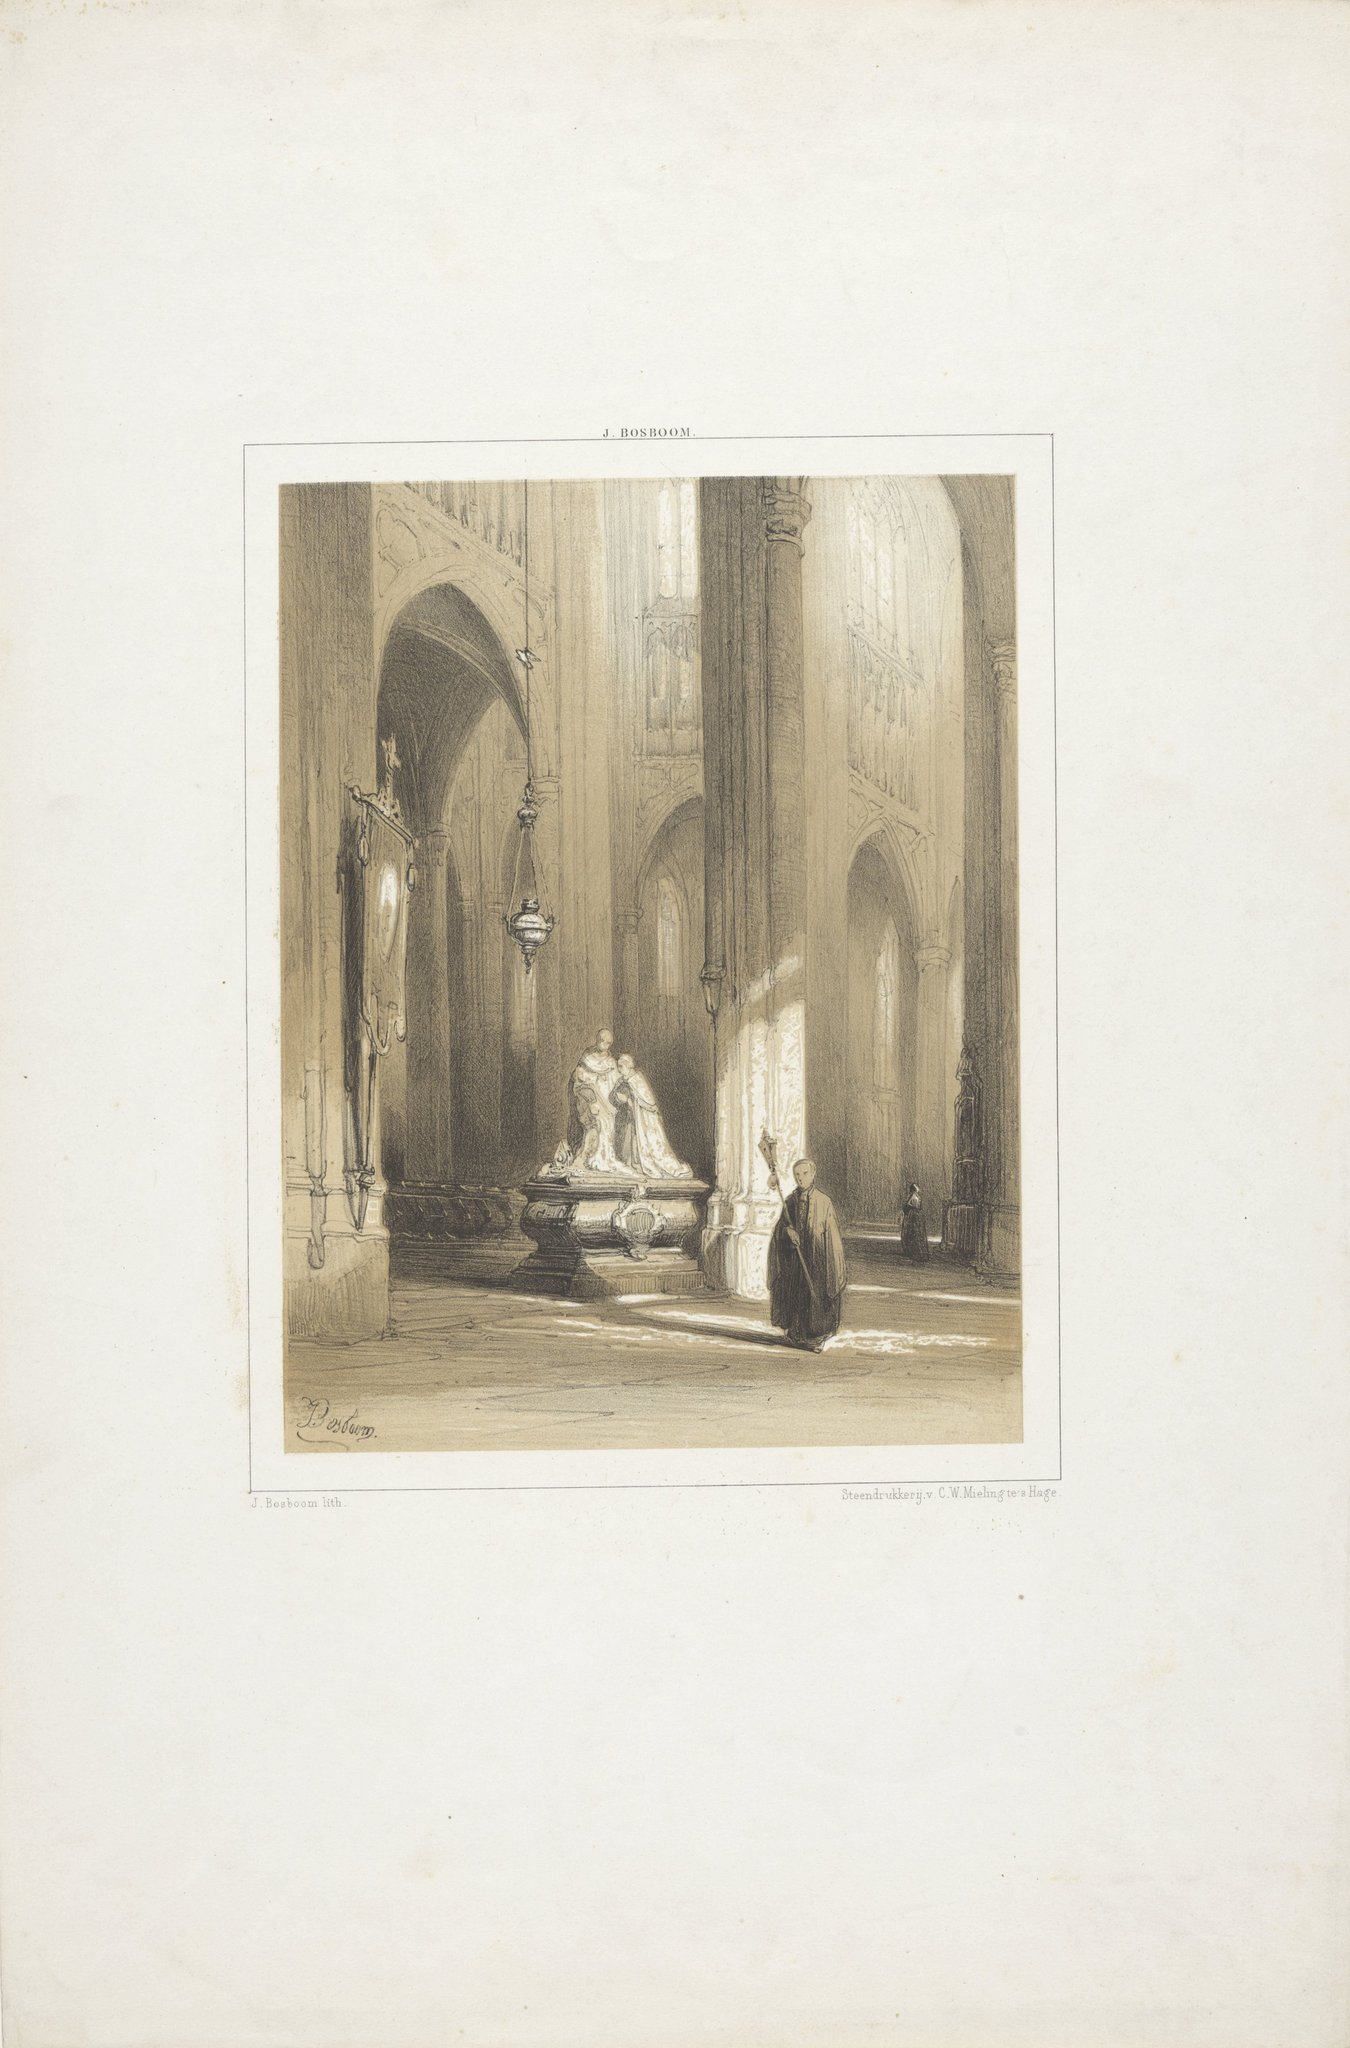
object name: print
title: Kerkinterieur met geestelijke en graftome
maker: johannes bosboom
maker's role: draughtsman, painter, print maker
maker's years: 1817-1891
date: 1827-1891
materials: paper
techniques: blind stamped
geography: netherlands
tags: interior of church, grave-building, monumental tomb, organization, functionaries and dignitaries in roman catholic church; clergy in general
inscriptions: collector's mark: Lugt 2228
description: Op de graftombe staan twee figuren, waarvan een geknield en in gebed. De geestelijke heeft een staf in zijn handen. Links aan de muur hangt een vaandel.